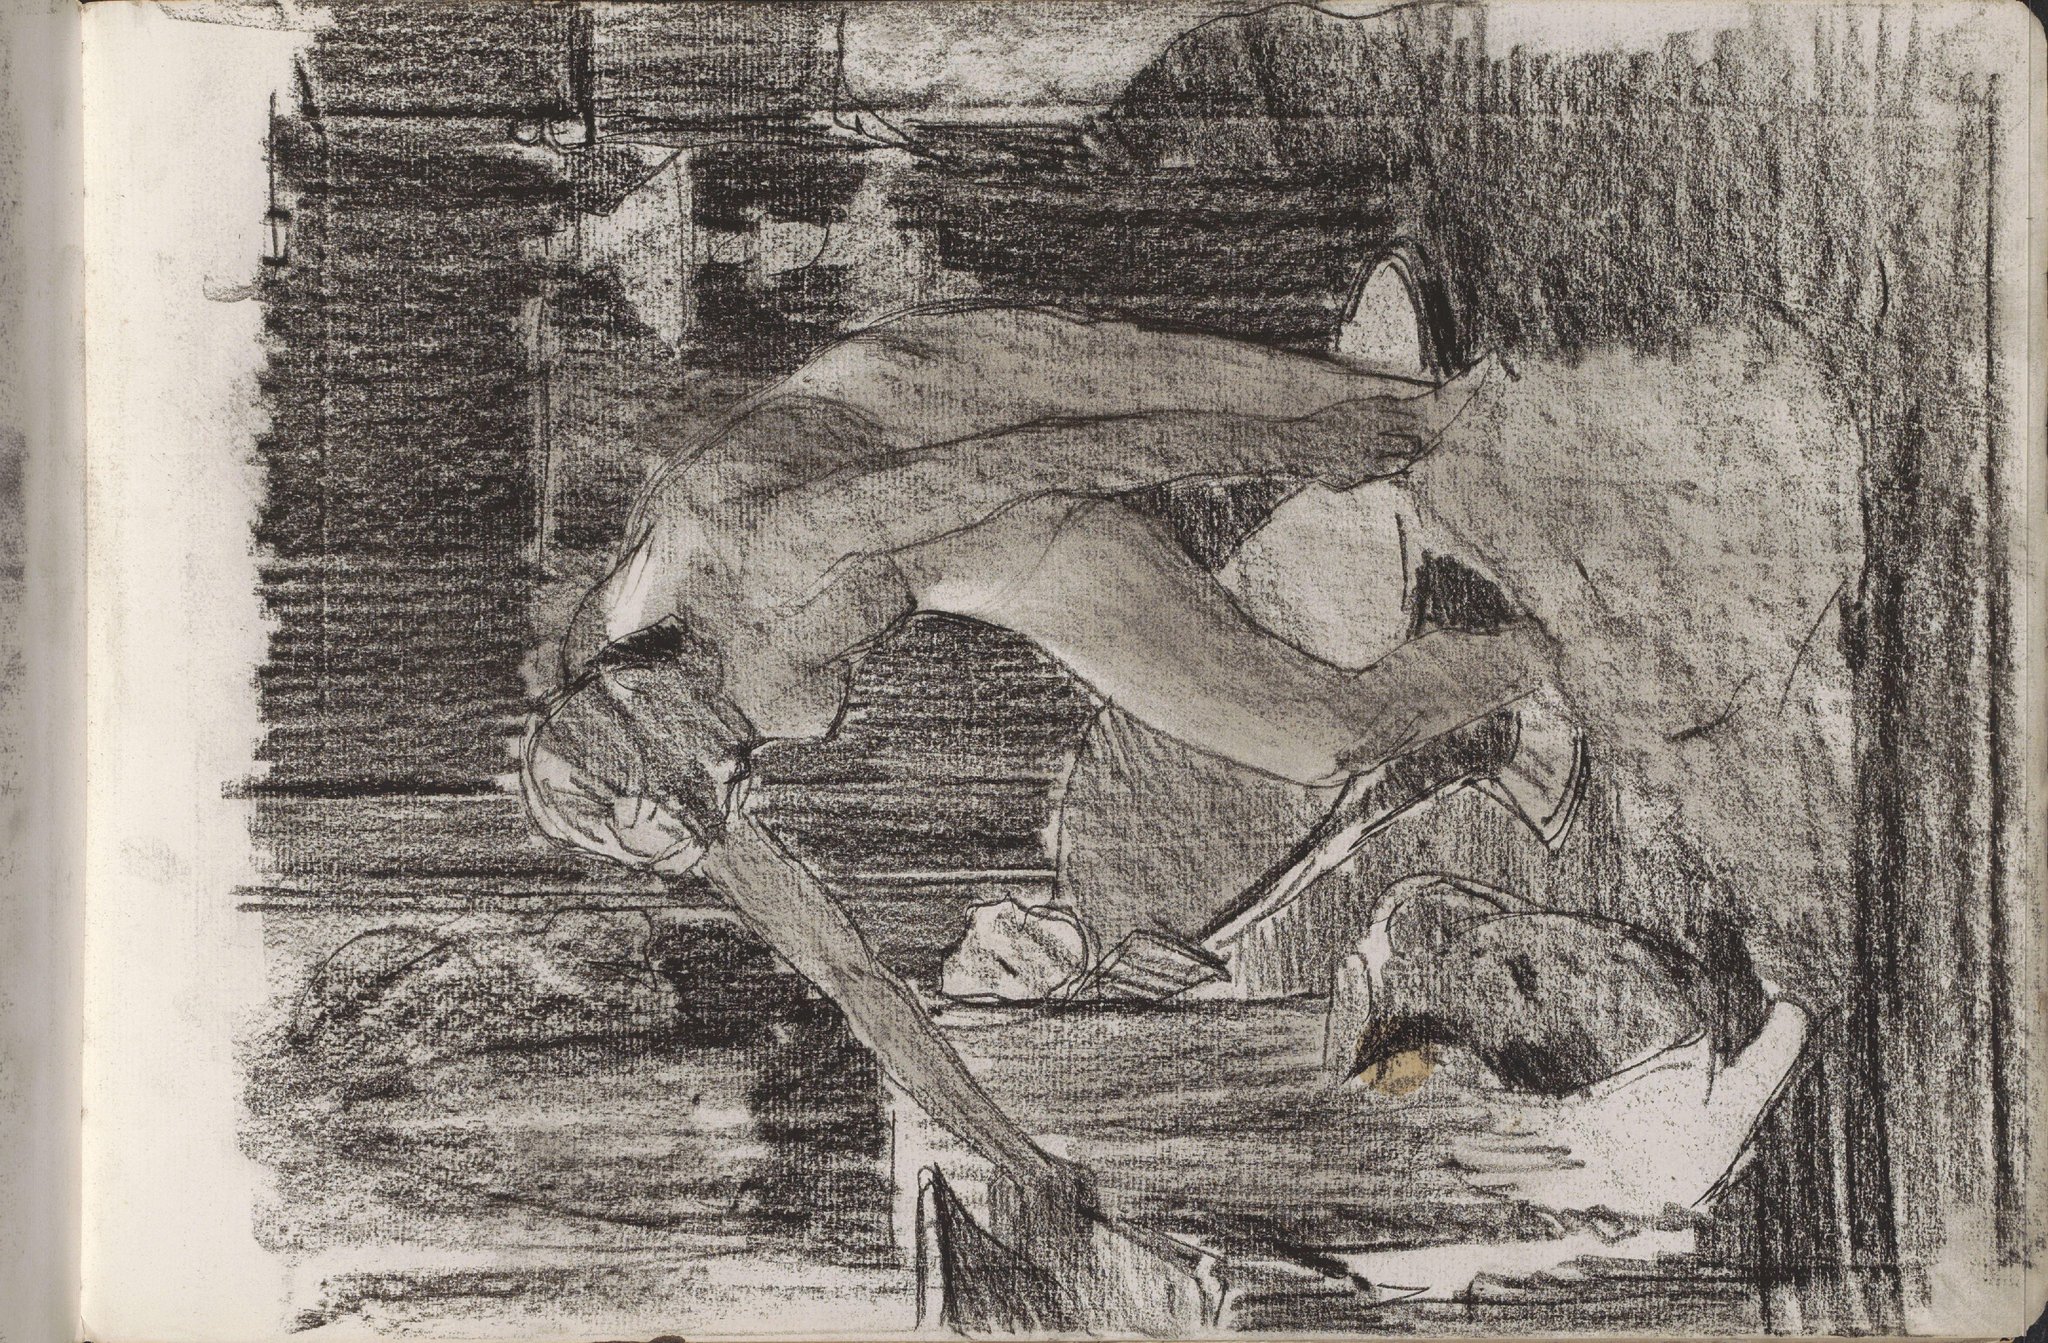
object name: sketchbook leaf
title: Vrouwelijk naakt in een slaapkamer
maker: willem witsen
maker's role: draughtsman, painter, print maker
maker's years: 1860-1923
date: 1887-1892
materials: chalk, paper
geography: amsterdam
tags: undressing oneself, getting undressed - aa - female human figure, the (nude) human figure; 'corpo humano' (ripa) - aa - female human figure, bedroom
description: Ze leunt op een wastafel terwijl ze zich uitkleedt. Achter haar mogelijk een bad of tobbe. Pagina 33 uit een schetsboek met 17 bladen.